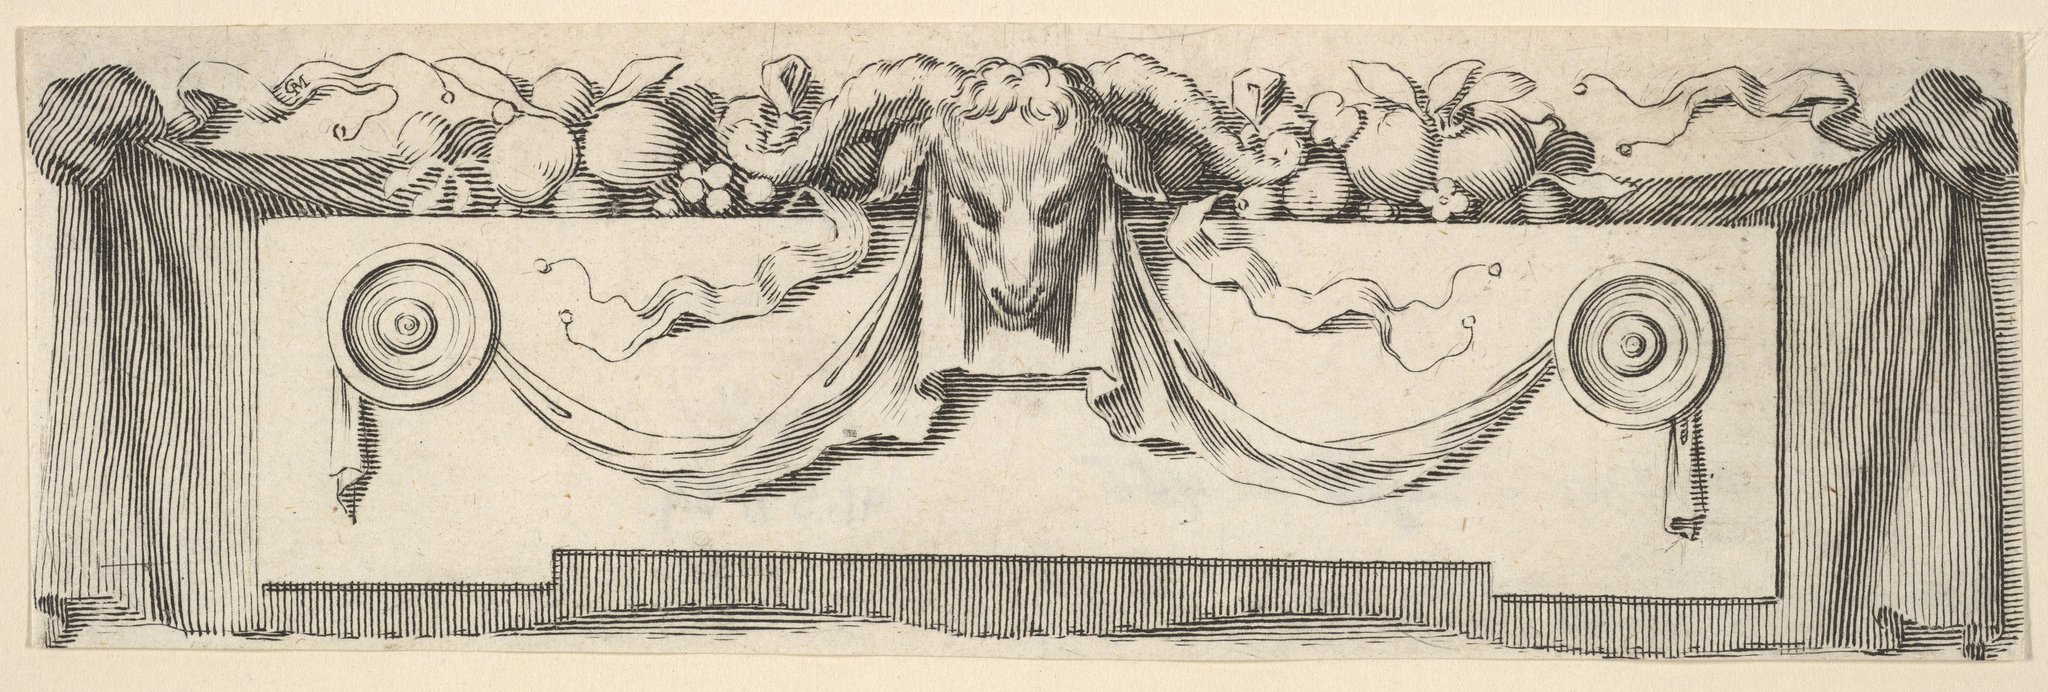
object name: print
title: Headband with Ram's Head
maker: claude mellan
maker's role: artist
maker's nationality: french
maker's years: 1598-1688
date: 1600-1688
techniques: engraving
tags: rams